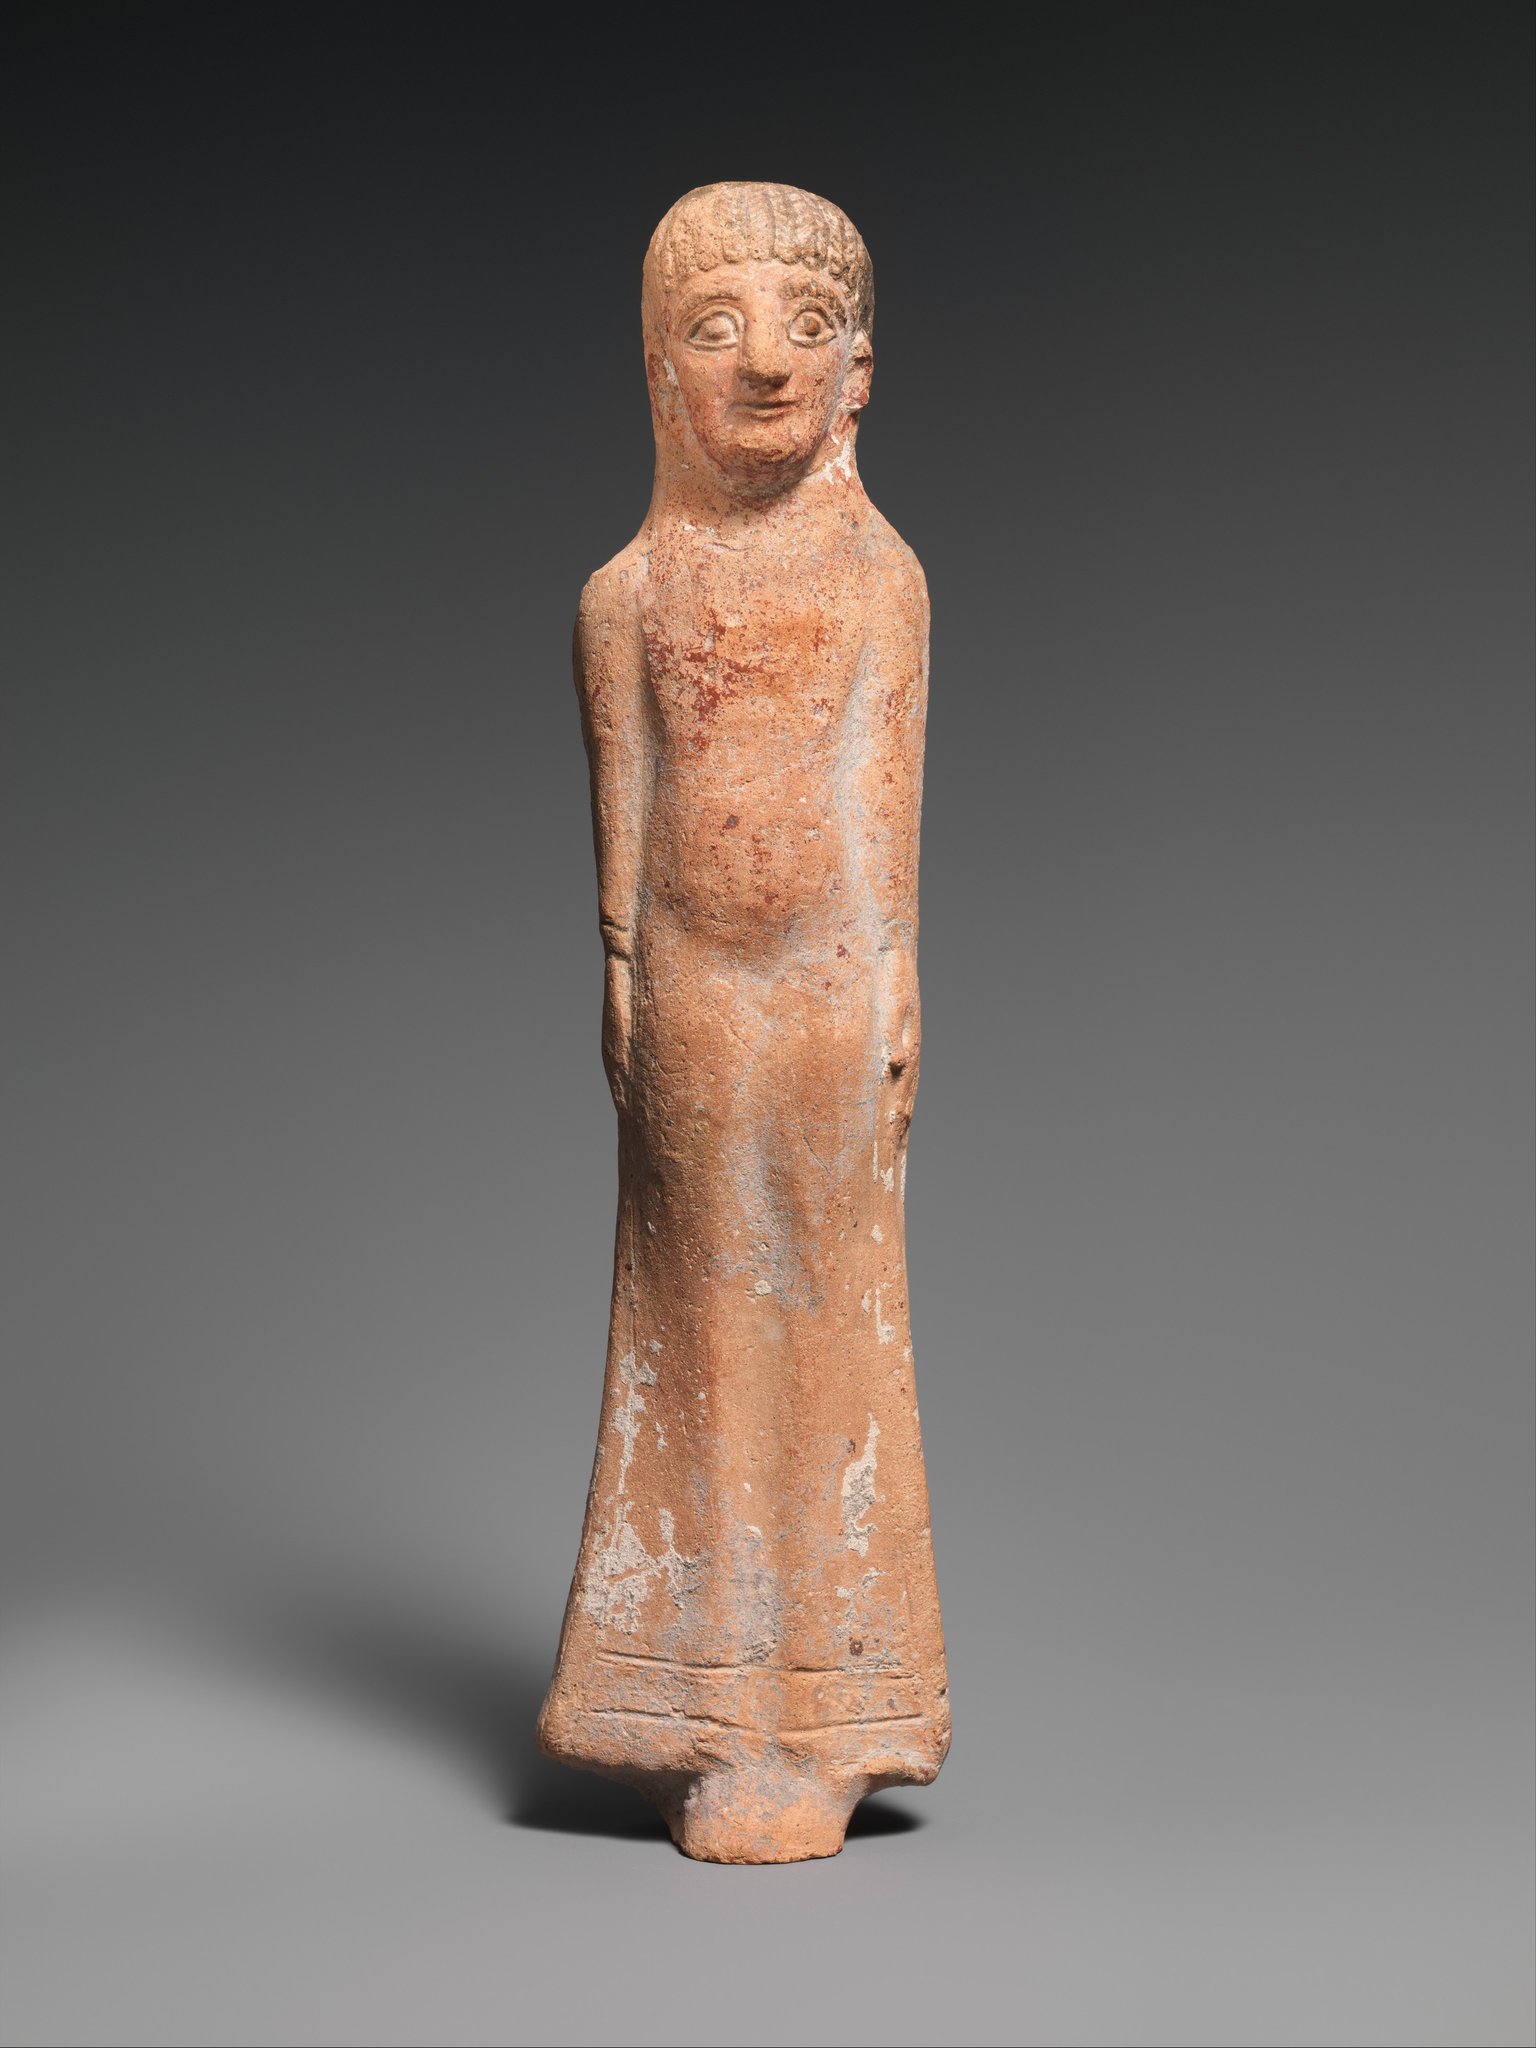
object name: statuette of a woman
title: Terracotta woman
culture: cypriot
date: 600-480 BCE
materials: terracotta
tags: women